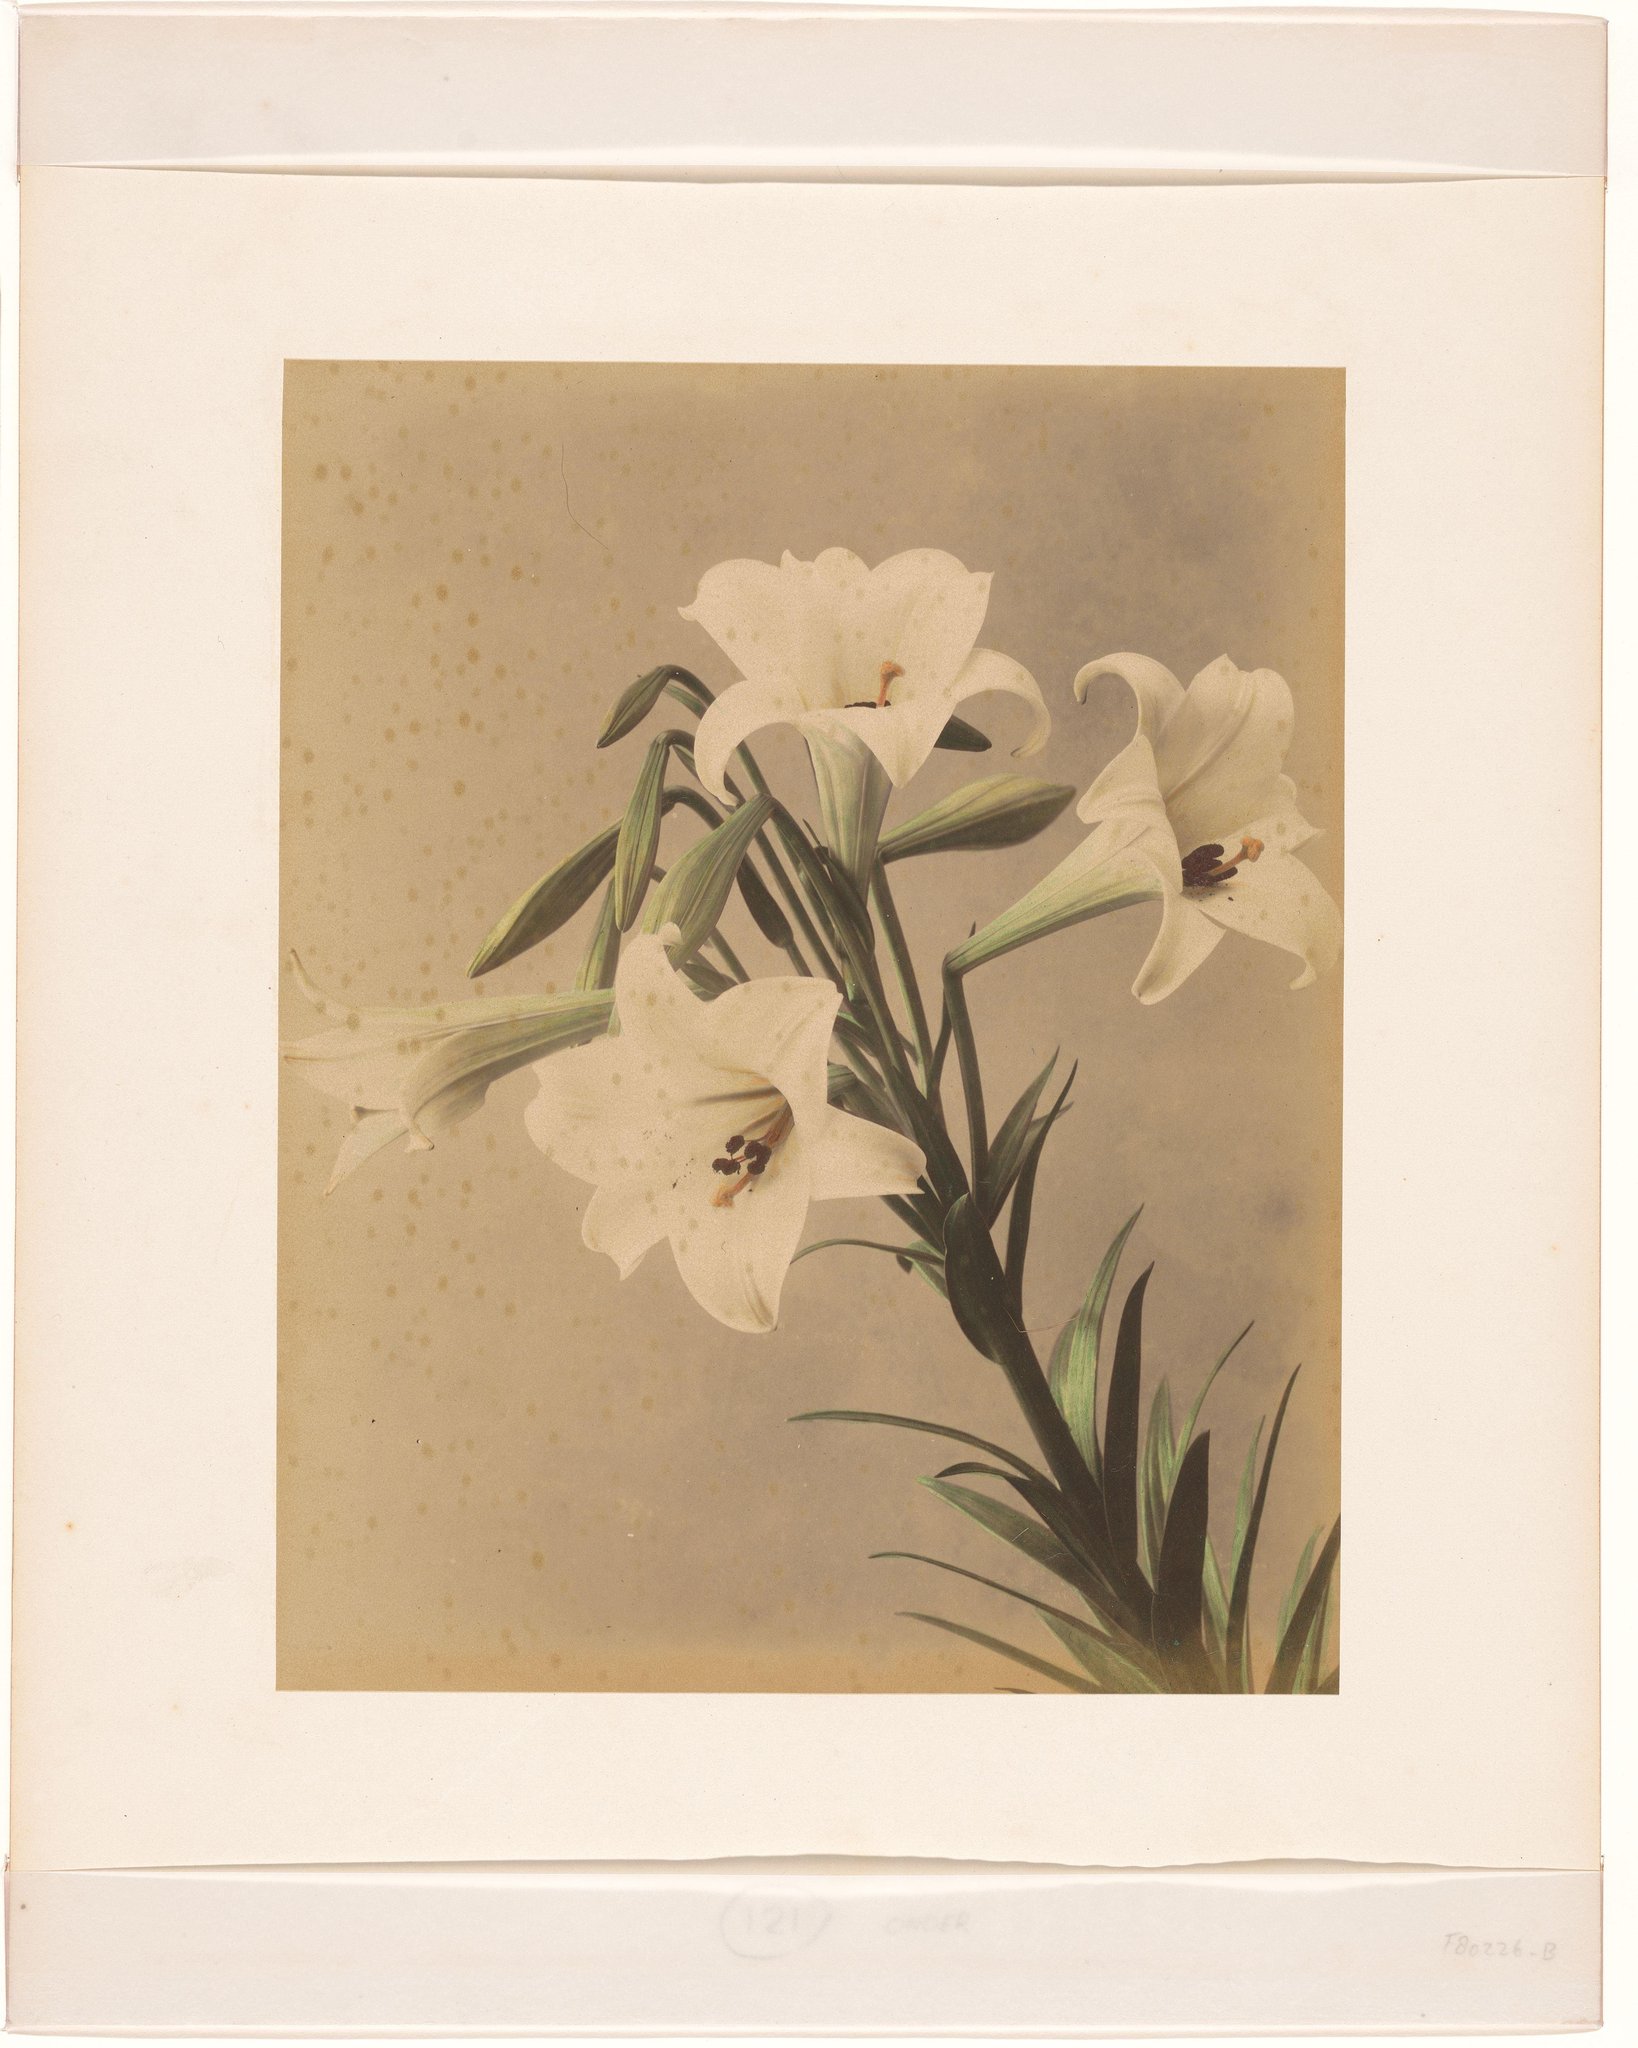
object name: photograph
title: Tak van de Japanse kers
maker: Anonymous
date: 1855-1890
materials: cardboard, paper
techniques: albumen print, hand coloring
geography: japan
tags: flowers, japan